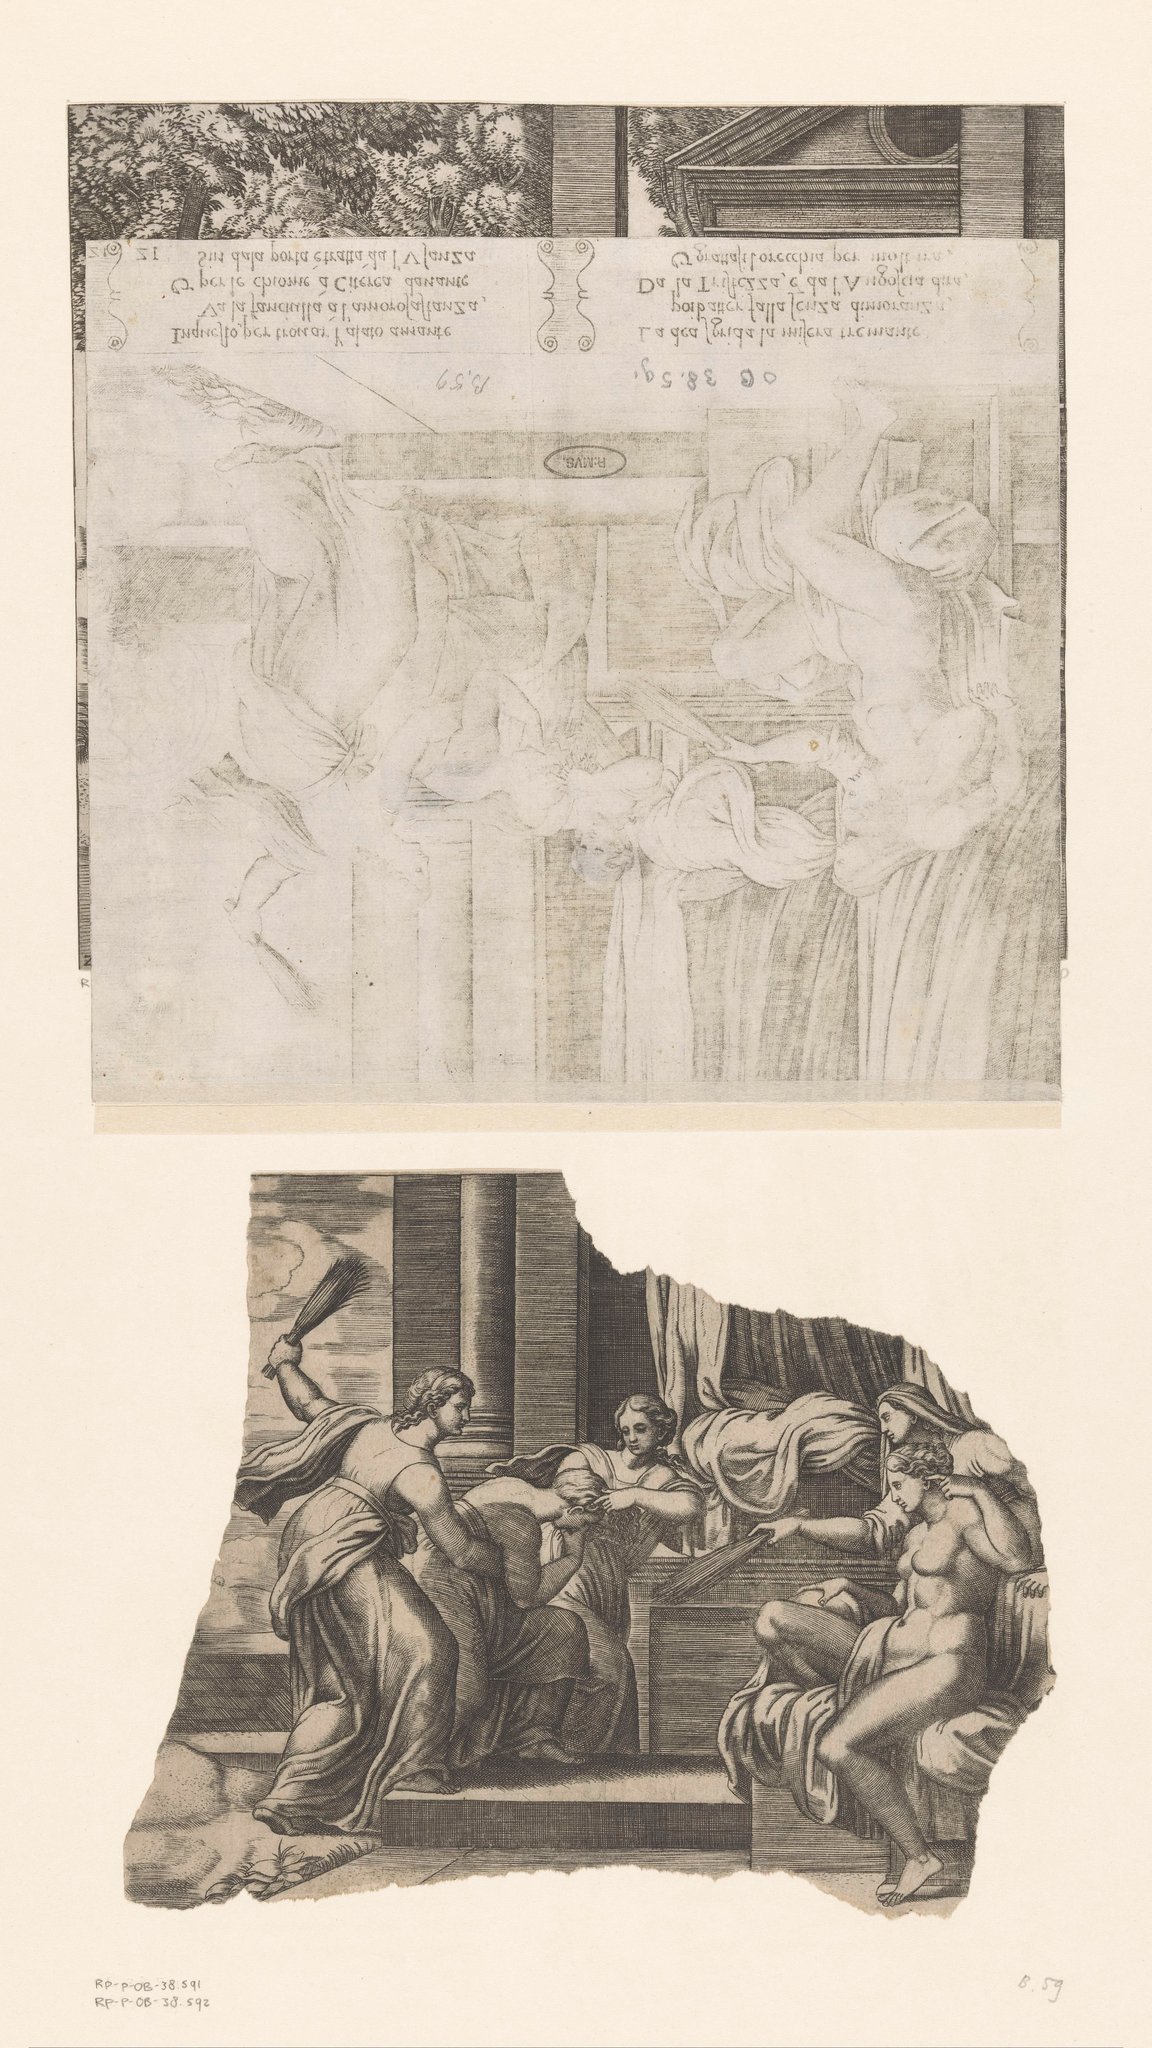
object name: print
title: Verhaal van Amor en Psyche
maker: meester van de dobbelsteen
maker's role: print maker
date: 1530-1560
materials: paper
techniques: engraving, intaglio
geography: italy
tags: pain, sorrow, sadness; 'dolore', 'dolore di zeusi' (ripa), other scenes from the story of cupid and psyche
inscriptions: collector's mark: Lugt 2228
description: Prent uit een serie met scènes uit het verhaal van Amor en Psyche naar ontwerp van Michiel Coxie, waarvan 29 prenten door de Meester van de Dobbelsteen en 3 door Agostino Veneziano. Rondom is een groot gedeelte van de prent afgescheurd.